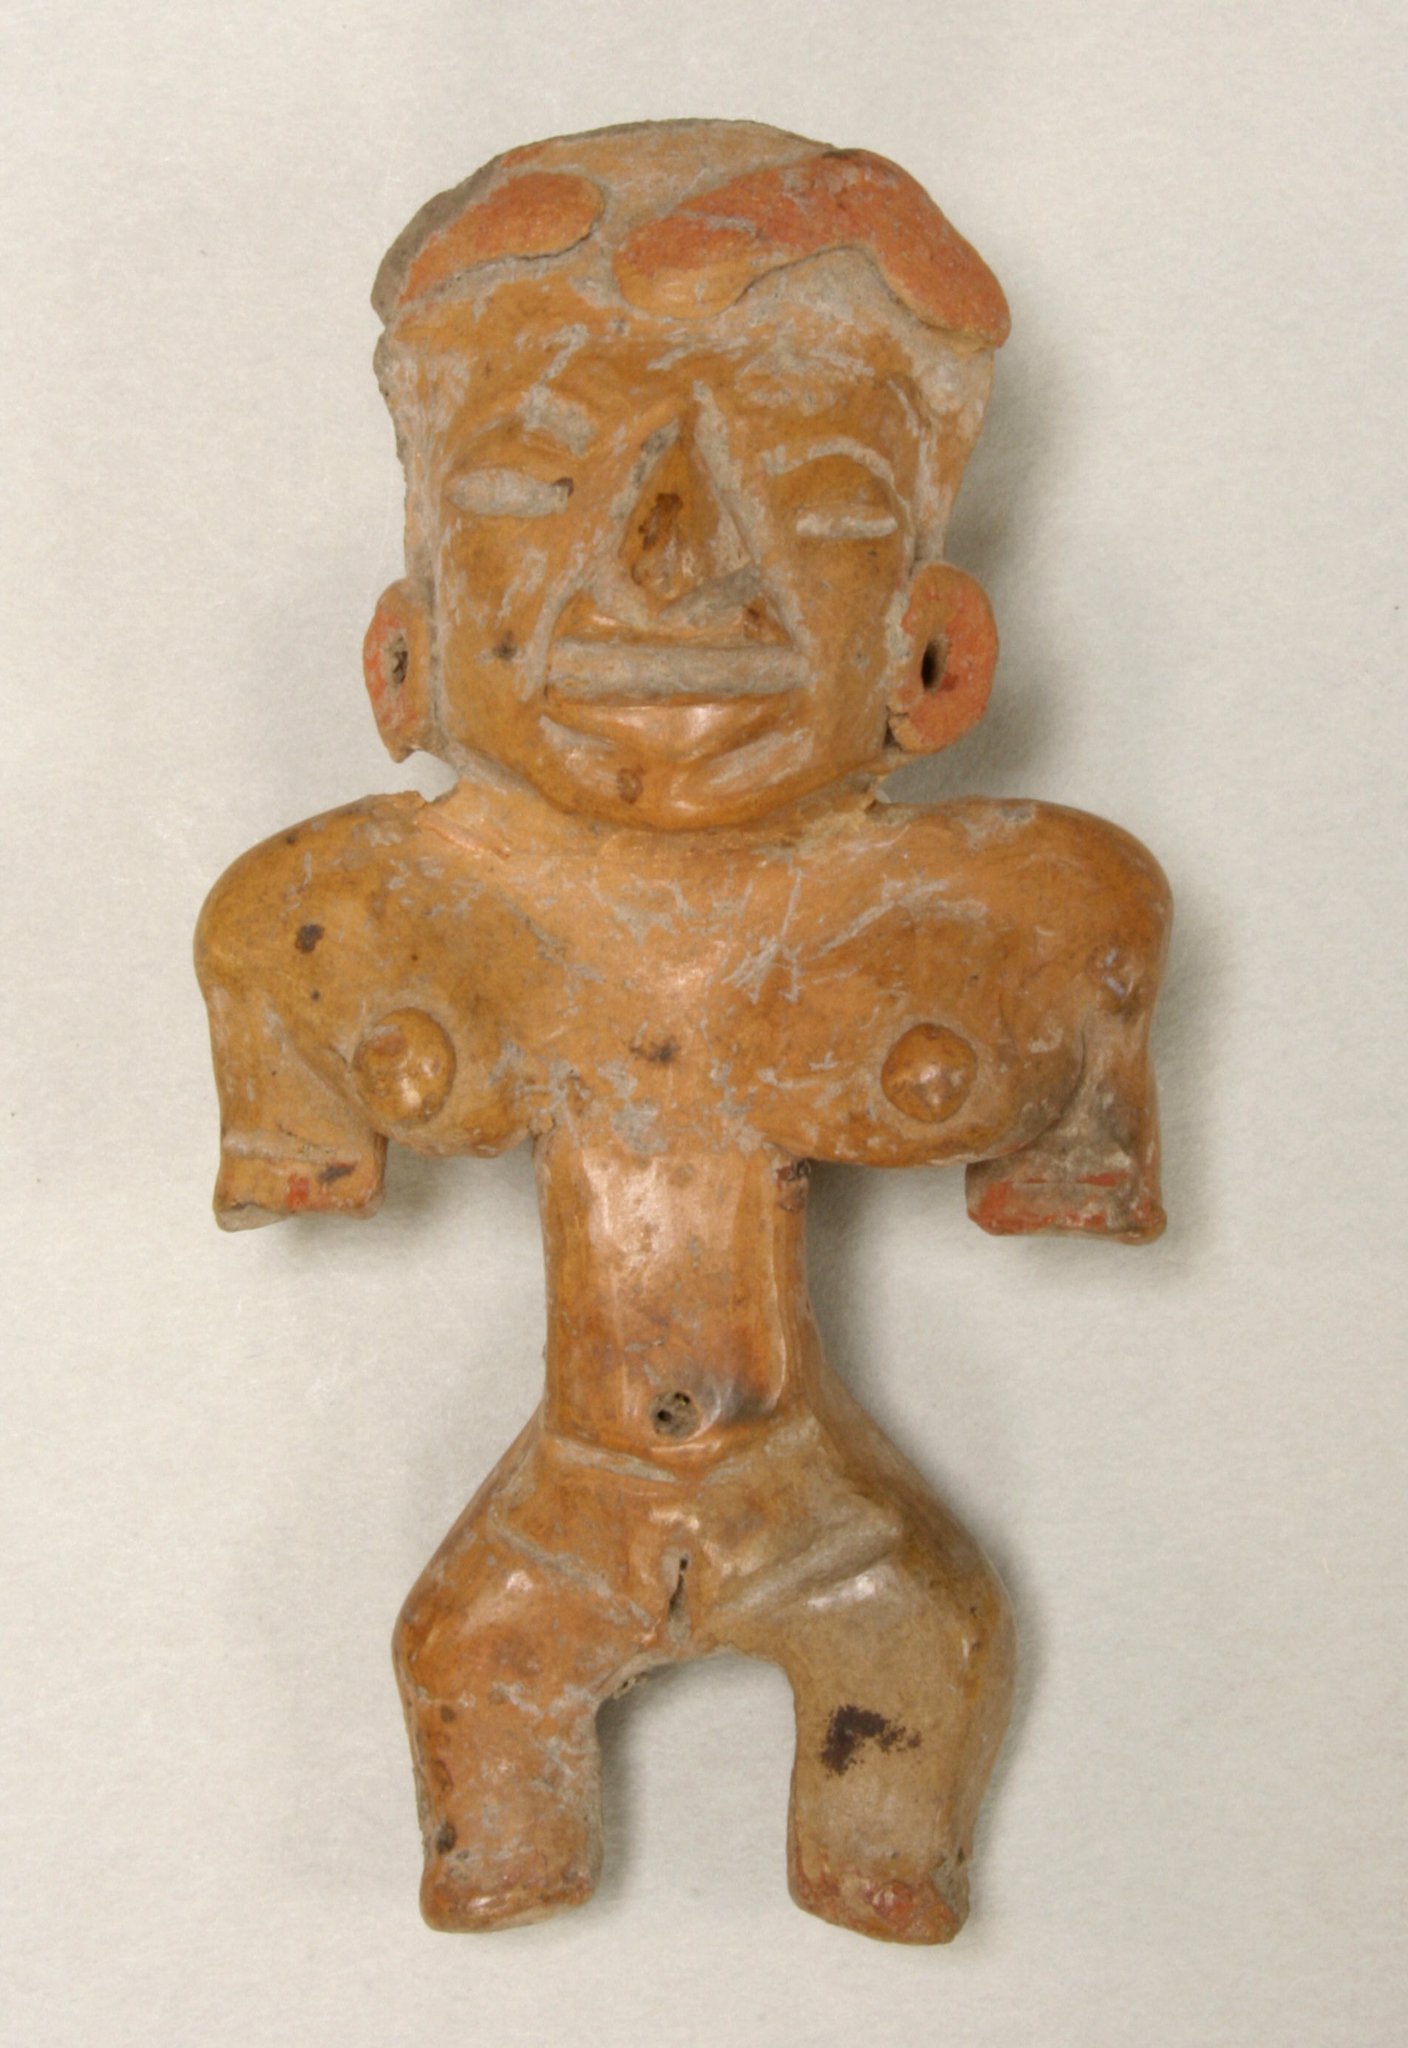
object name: female figure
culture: ticoman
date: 1200-801 BCE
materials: ceramic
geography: mexico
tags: women